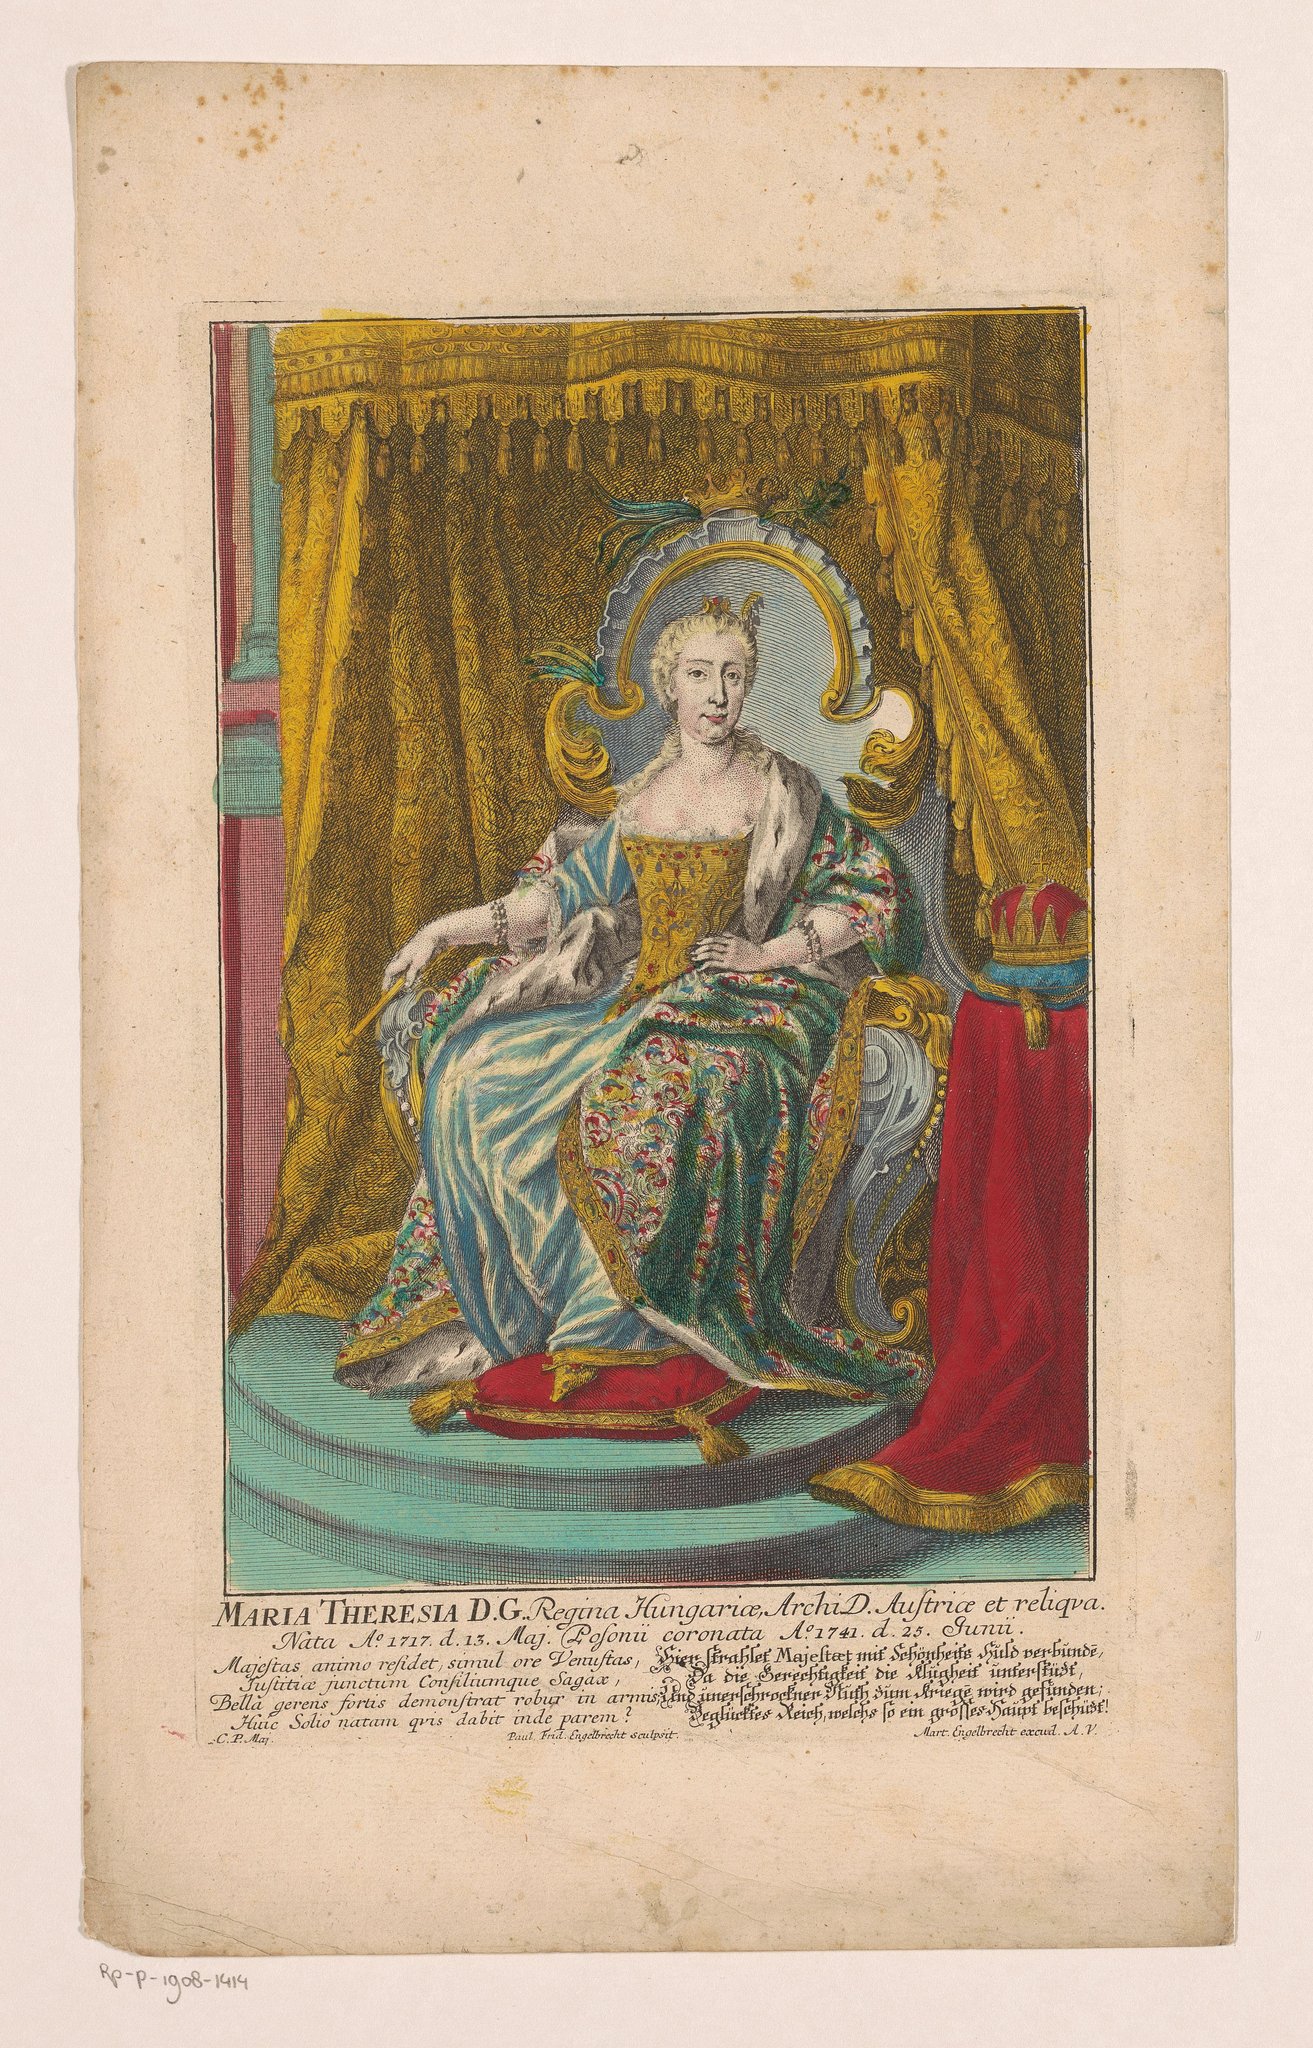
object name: print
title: Portret van Maria Theresia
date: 1741-1757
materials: paper, watercolor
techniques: engraving, etching, hand coloring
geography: augsburg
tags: vienna, maria theresia (rooms-duits keizerin), crown (symbol of sovereignty), canopy, baldachin, historical persons - bb - woman, ruler, sovereign - bb - female ruler, throne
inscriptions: collector's mark: Lugt 2228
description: Met onderschrift in het Latijn en het Duits.